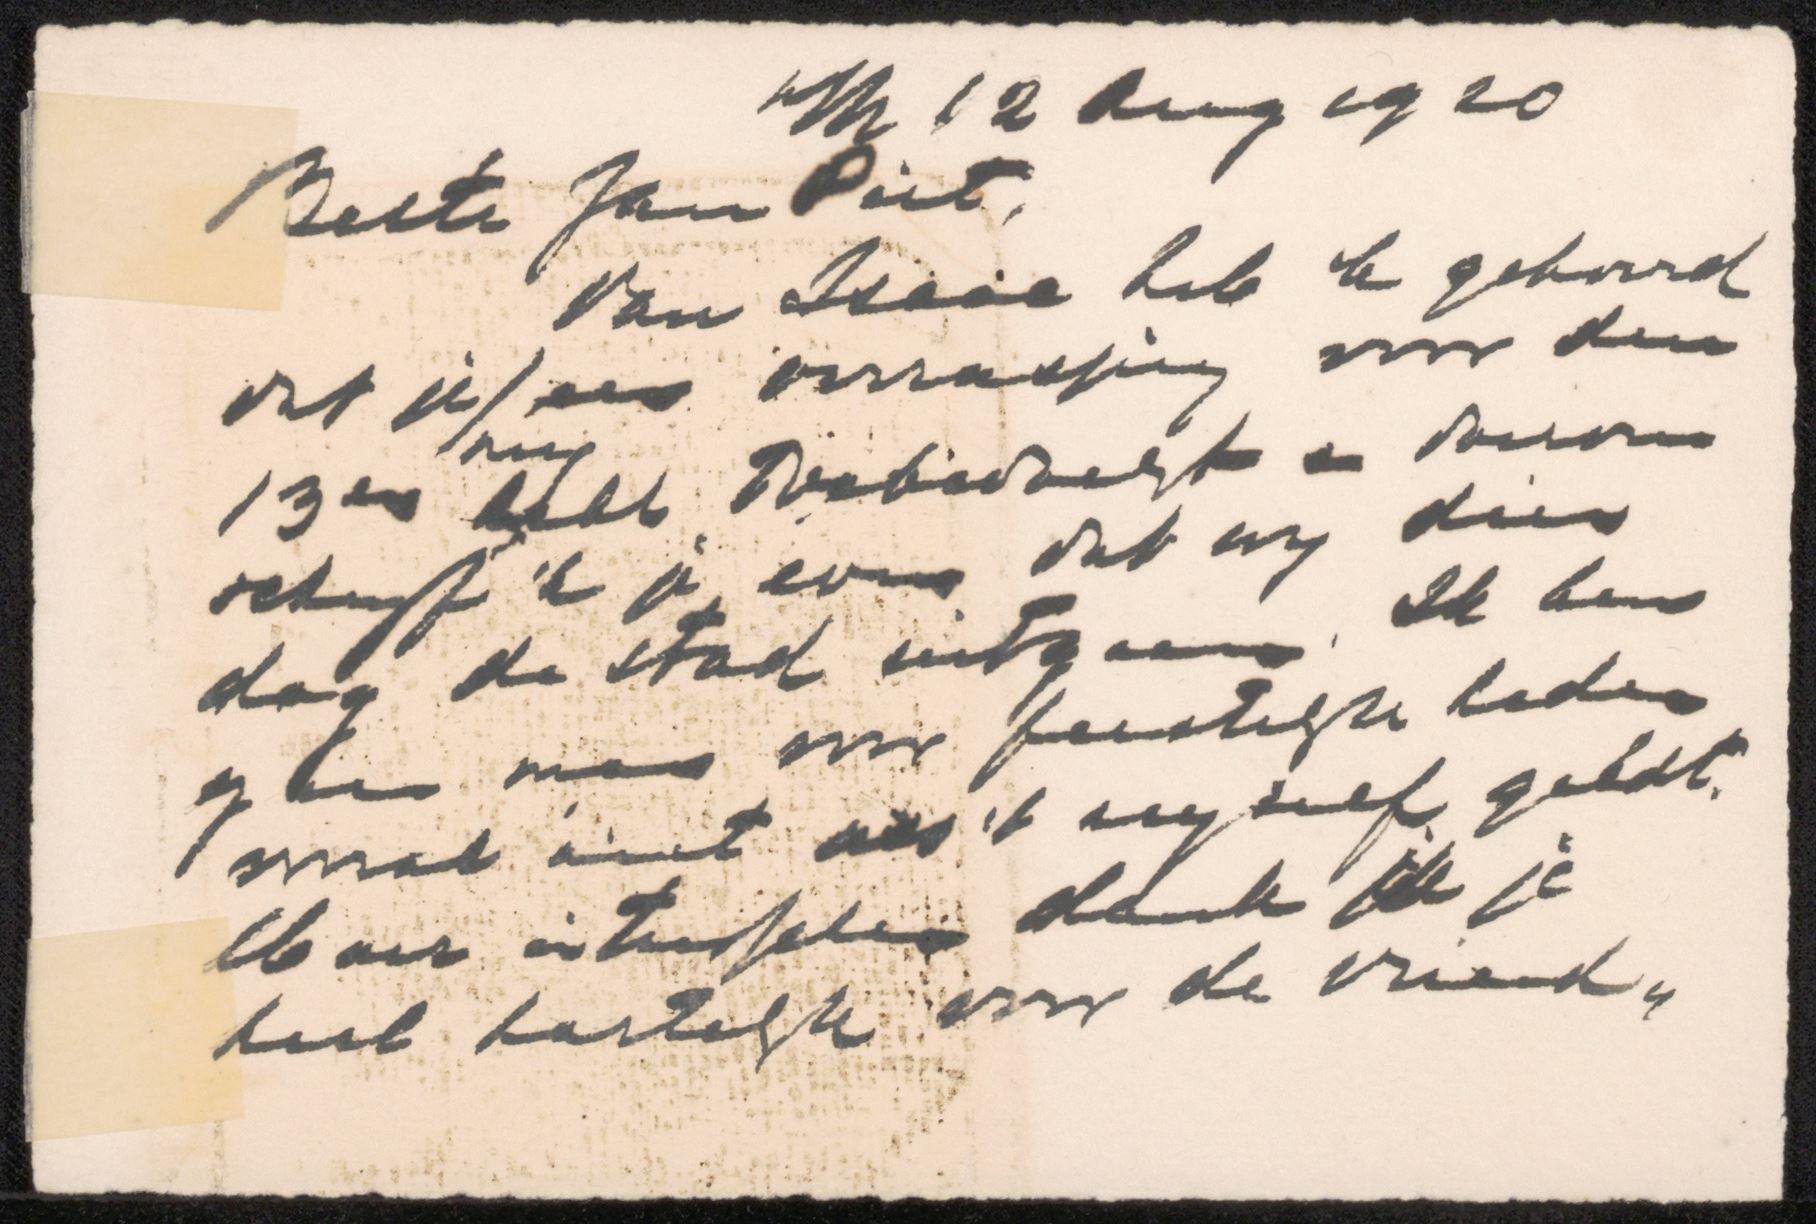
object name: letter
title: Brief aan Jan Veth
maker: willem witsen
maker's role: draughtsman, painter, print maker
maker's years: 1860-1923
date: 1920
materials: cardboard, ink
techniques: pen, writing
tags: designer, jan veth, isaac israels, travelling; tourism, dutch east indies, the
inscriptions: collector's mark: ‘RPK’